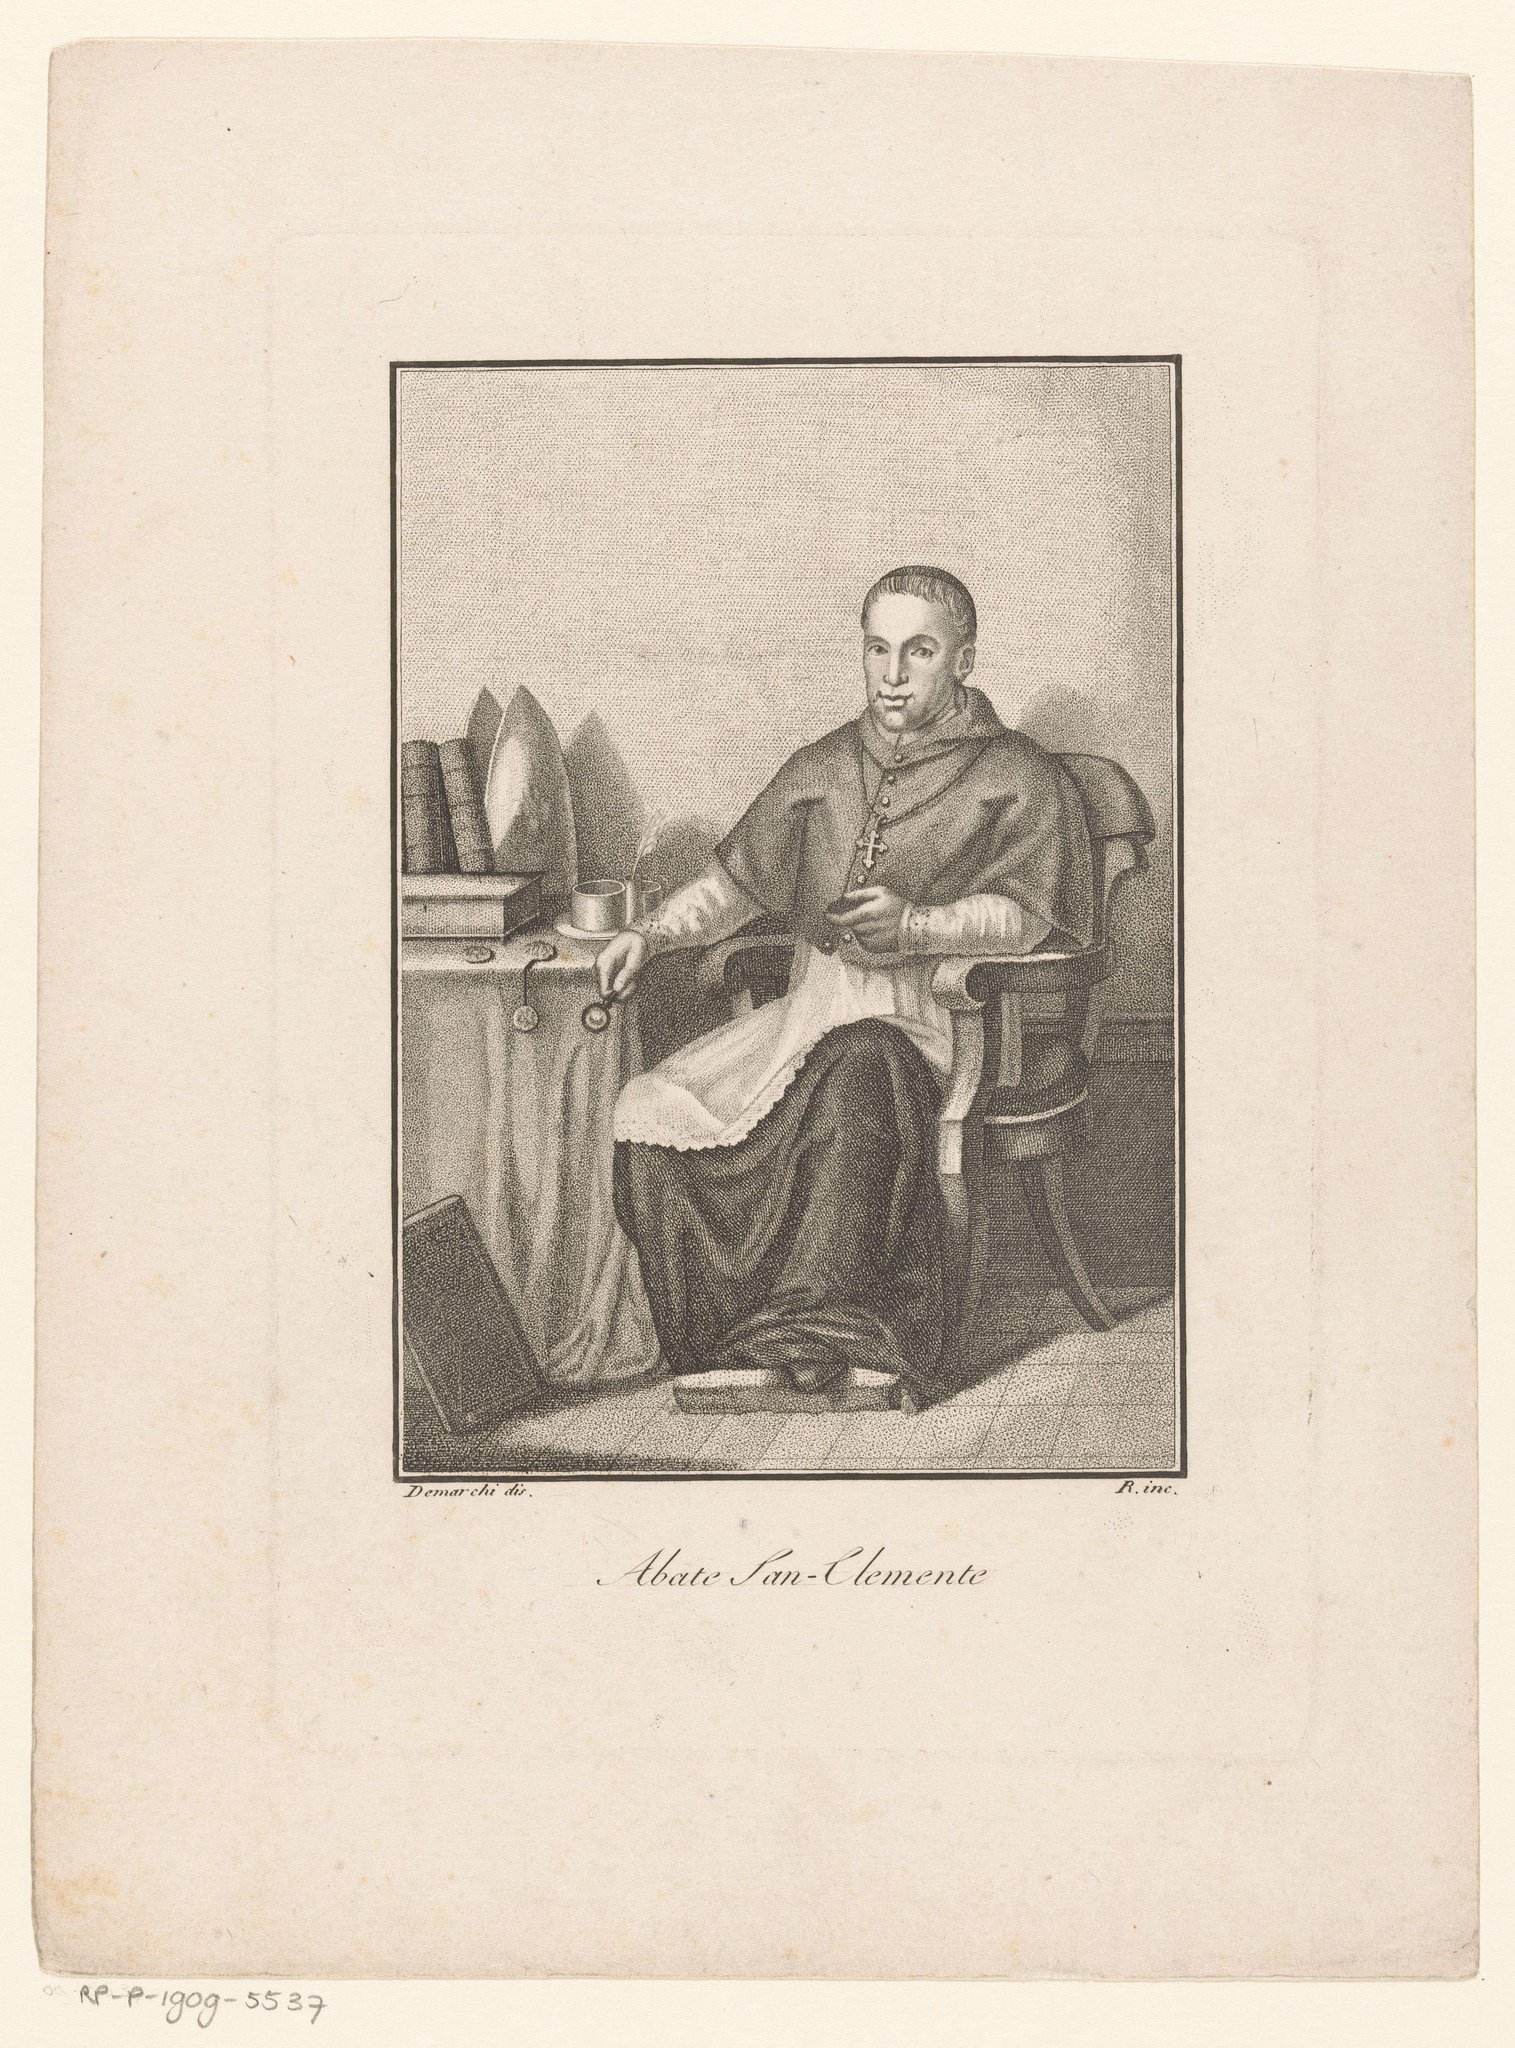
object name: print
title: Portret van de abt van San Clemente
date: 1800-1899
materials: paper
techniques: engraving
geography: italy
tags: abbot, historical persons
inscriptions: collector's mark: Lugt 2228